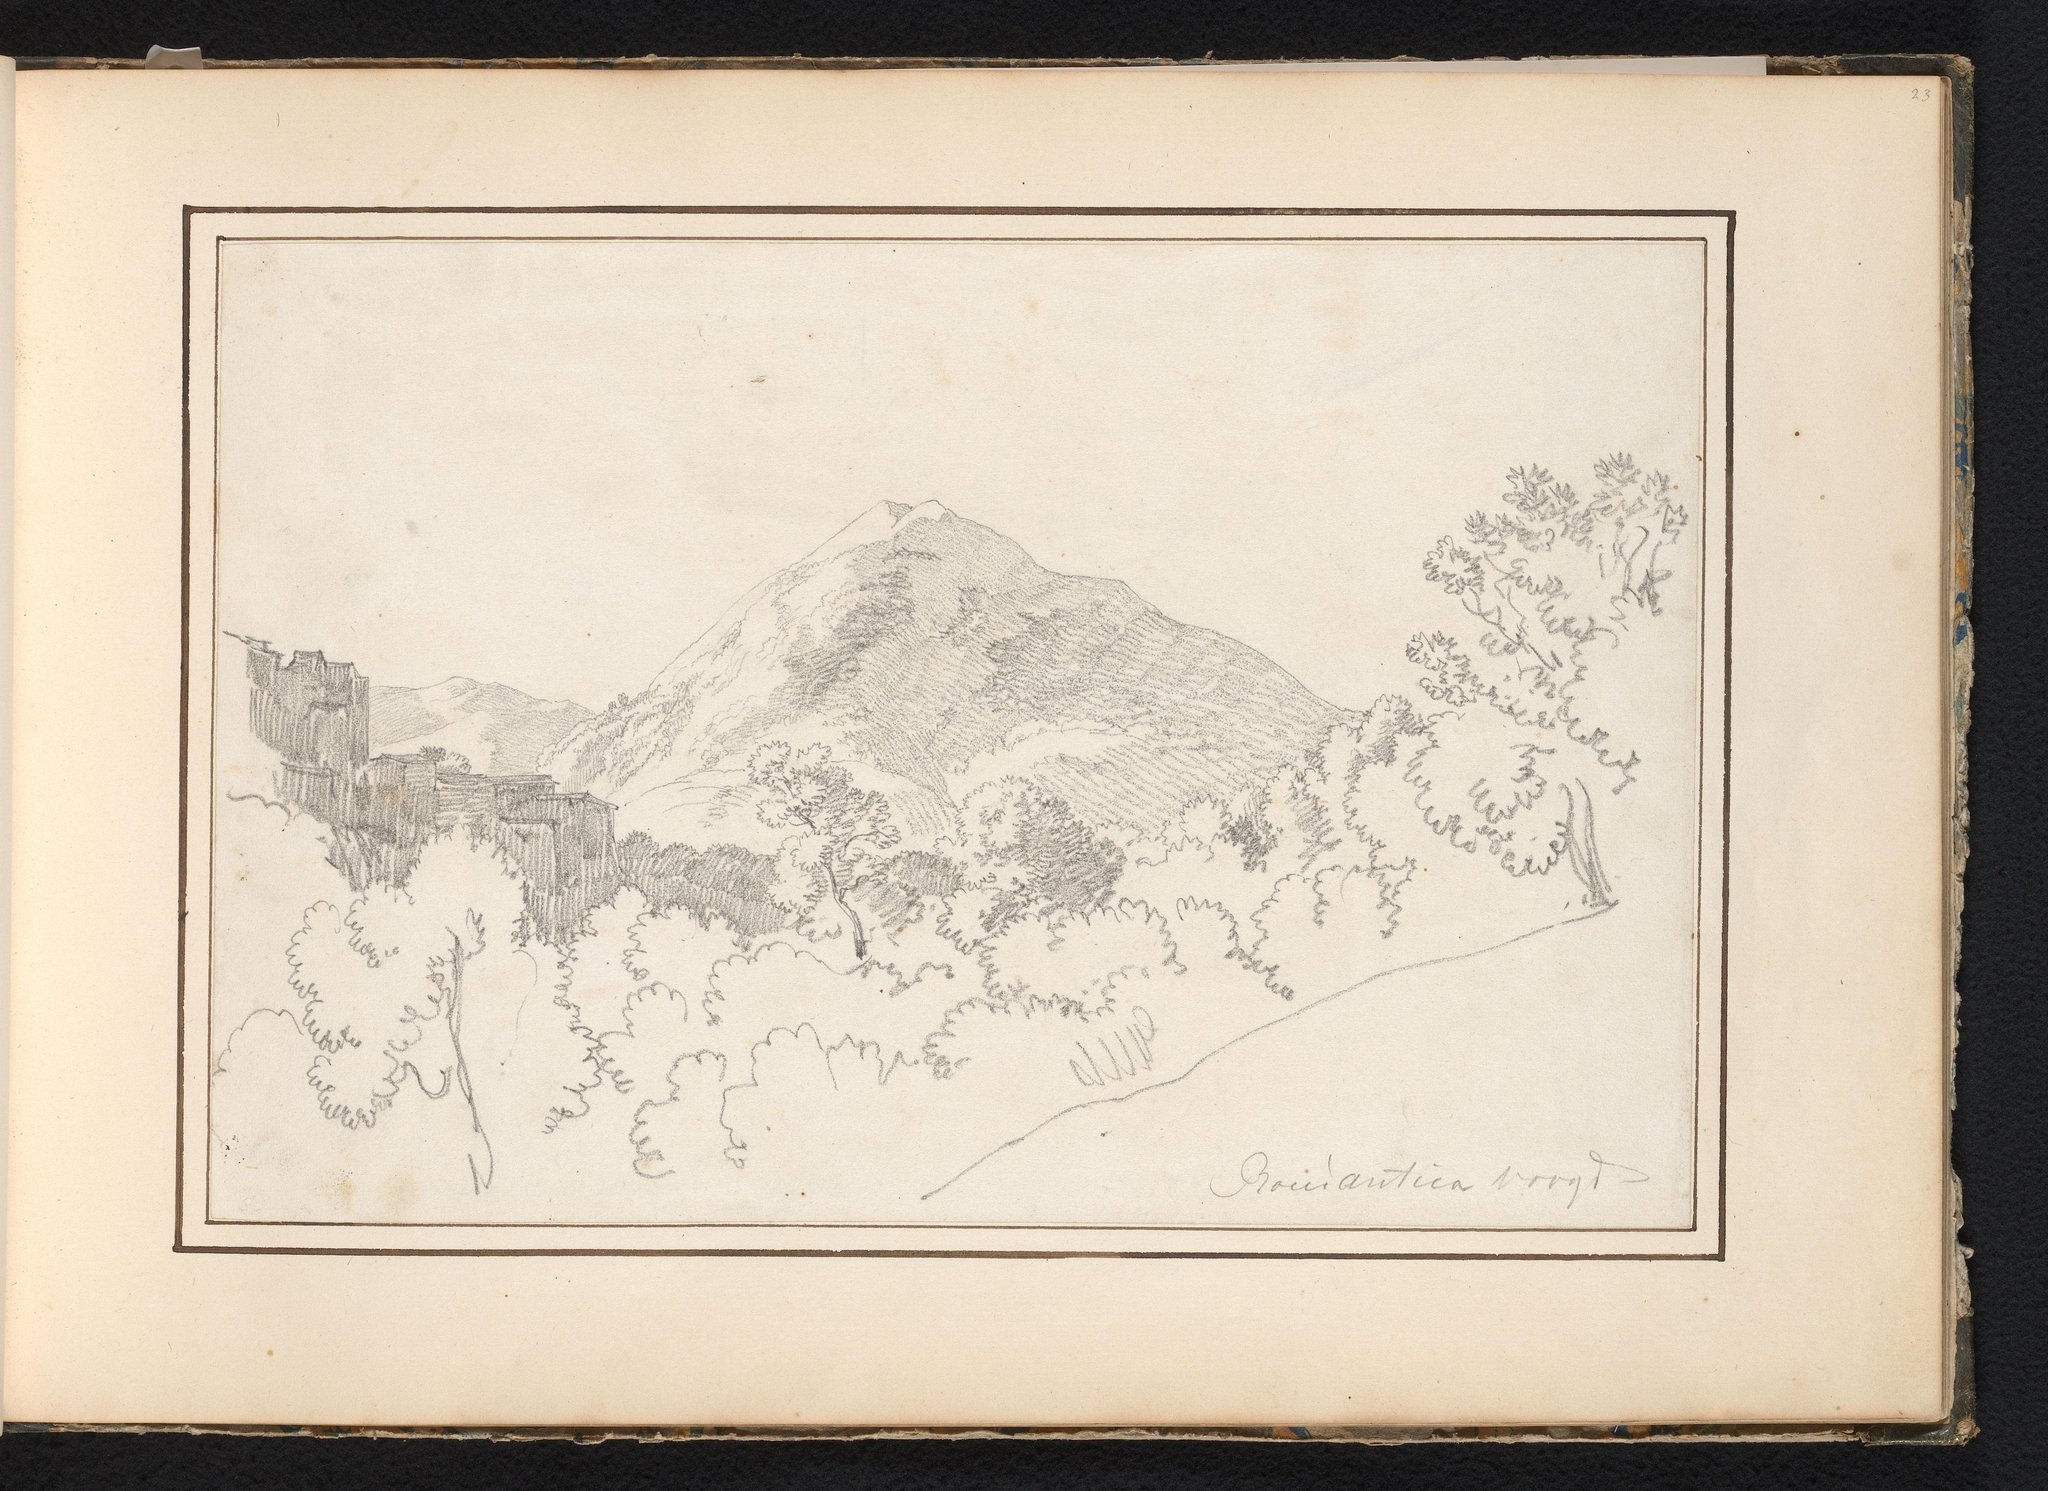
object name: album leaf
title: Vergezicht met bergtop te Roccantica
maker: hendrik voogd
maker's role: draughtsman, painter, print maker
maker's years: 1768-1839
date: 1788-1839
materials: paper, pencil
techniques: pasting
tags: city-view, and landscape with man-made constructions, mountain-top, peak, roccantica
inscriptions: inscription: ‘Rocc'antica’